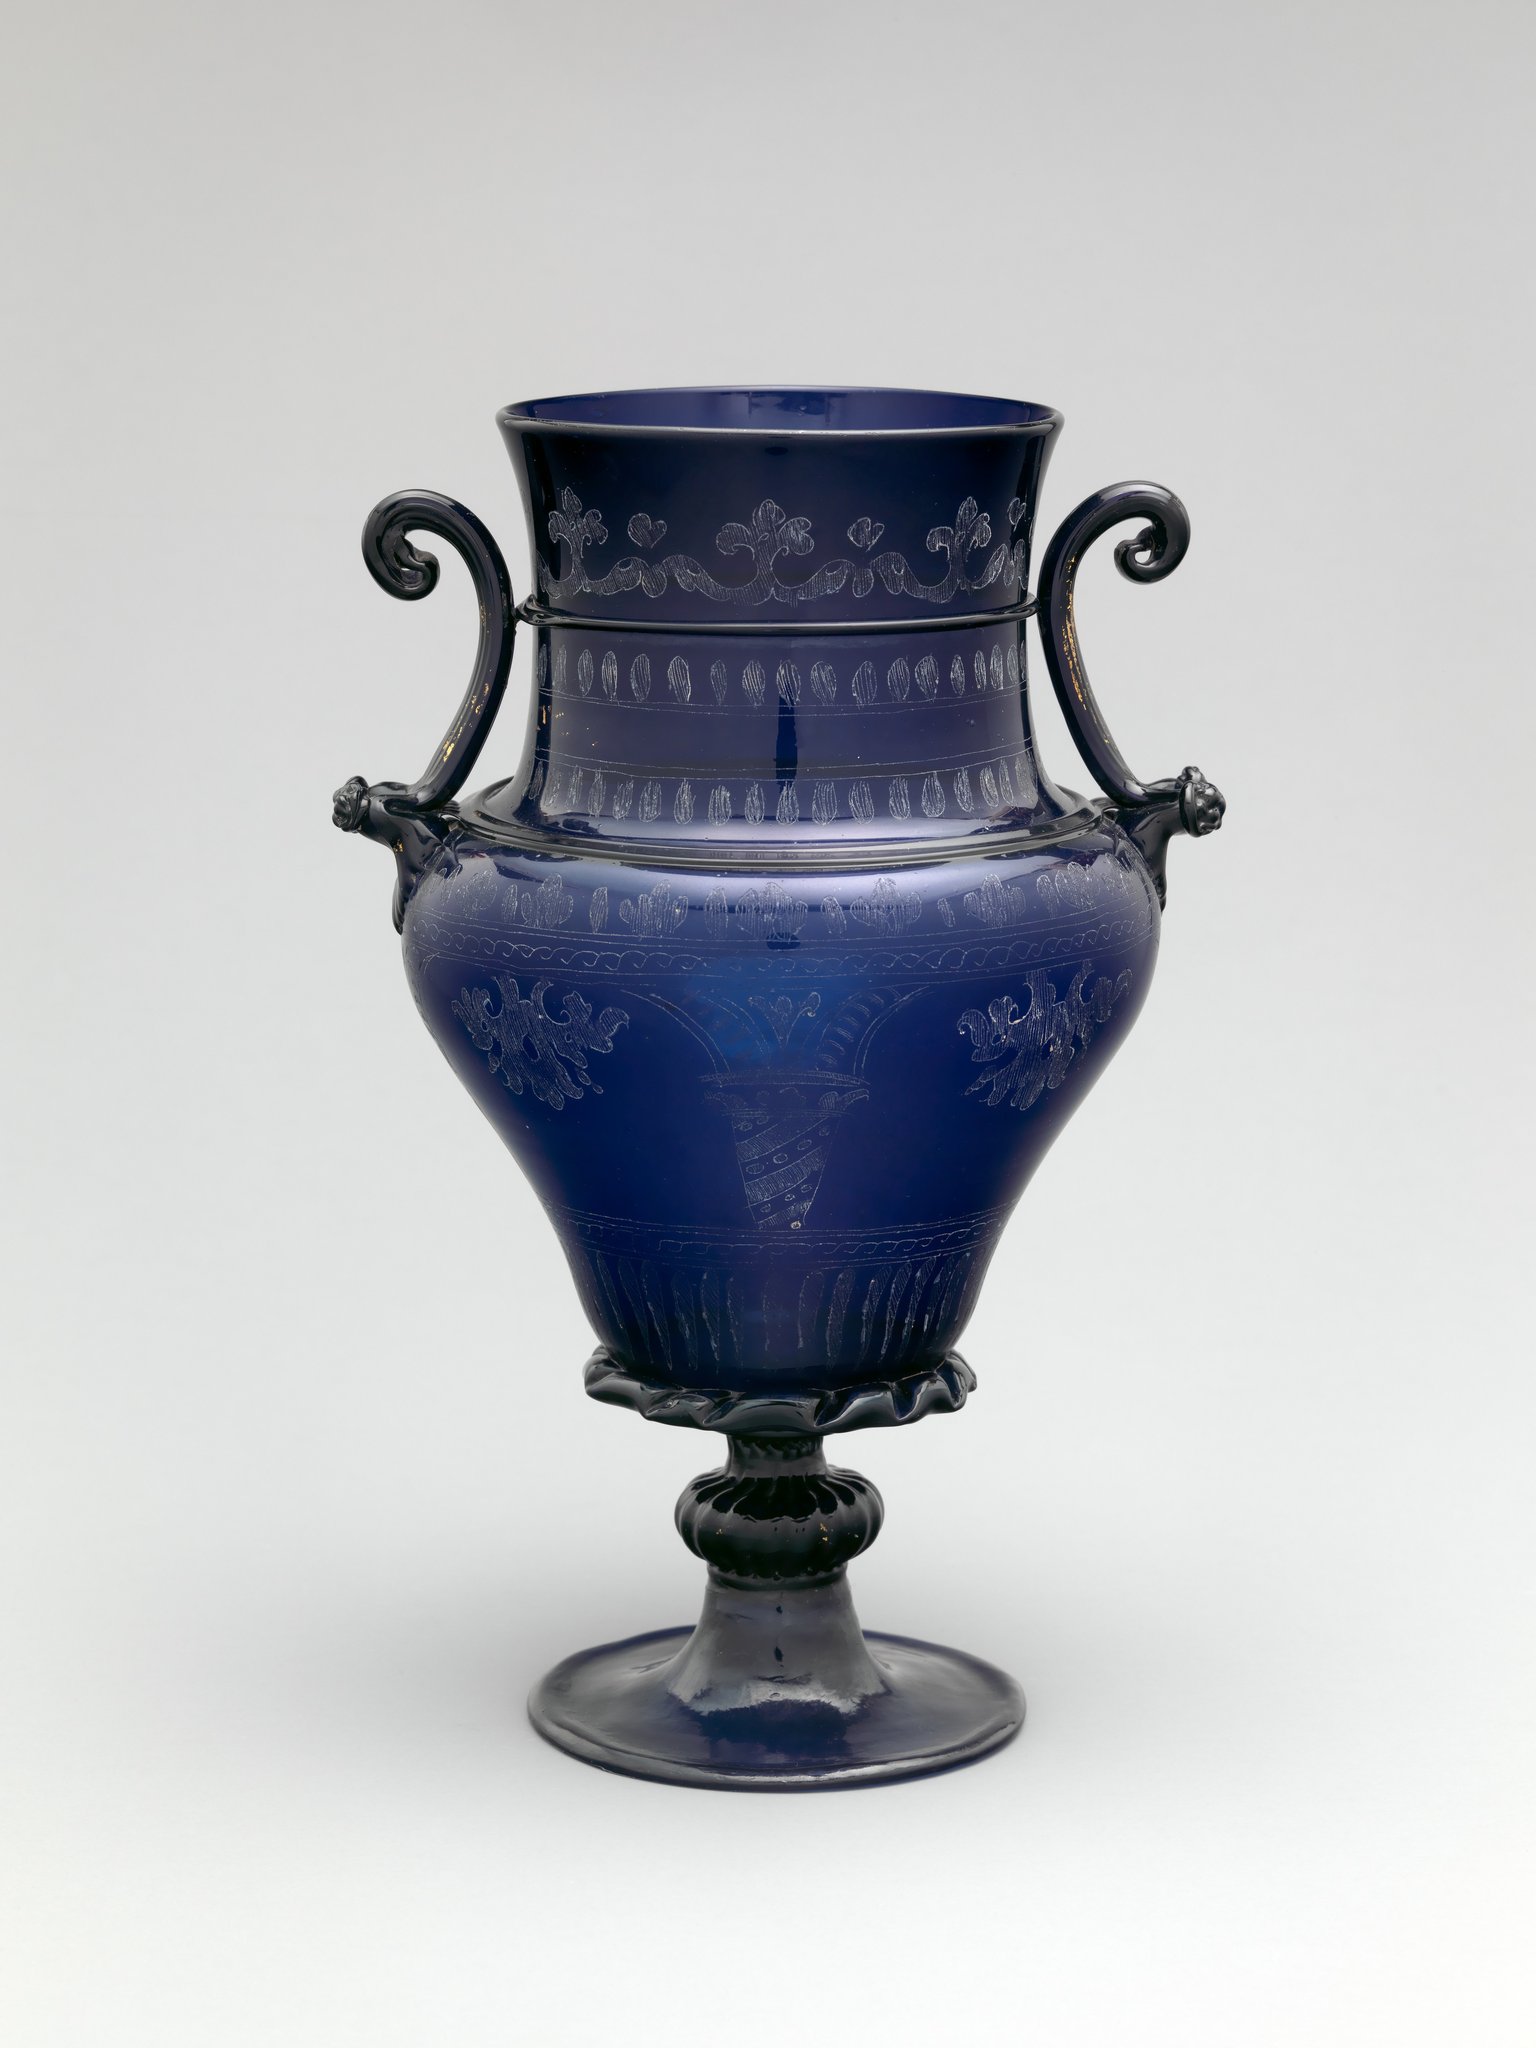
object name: vase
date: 1550-1600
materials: glass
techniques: engraving